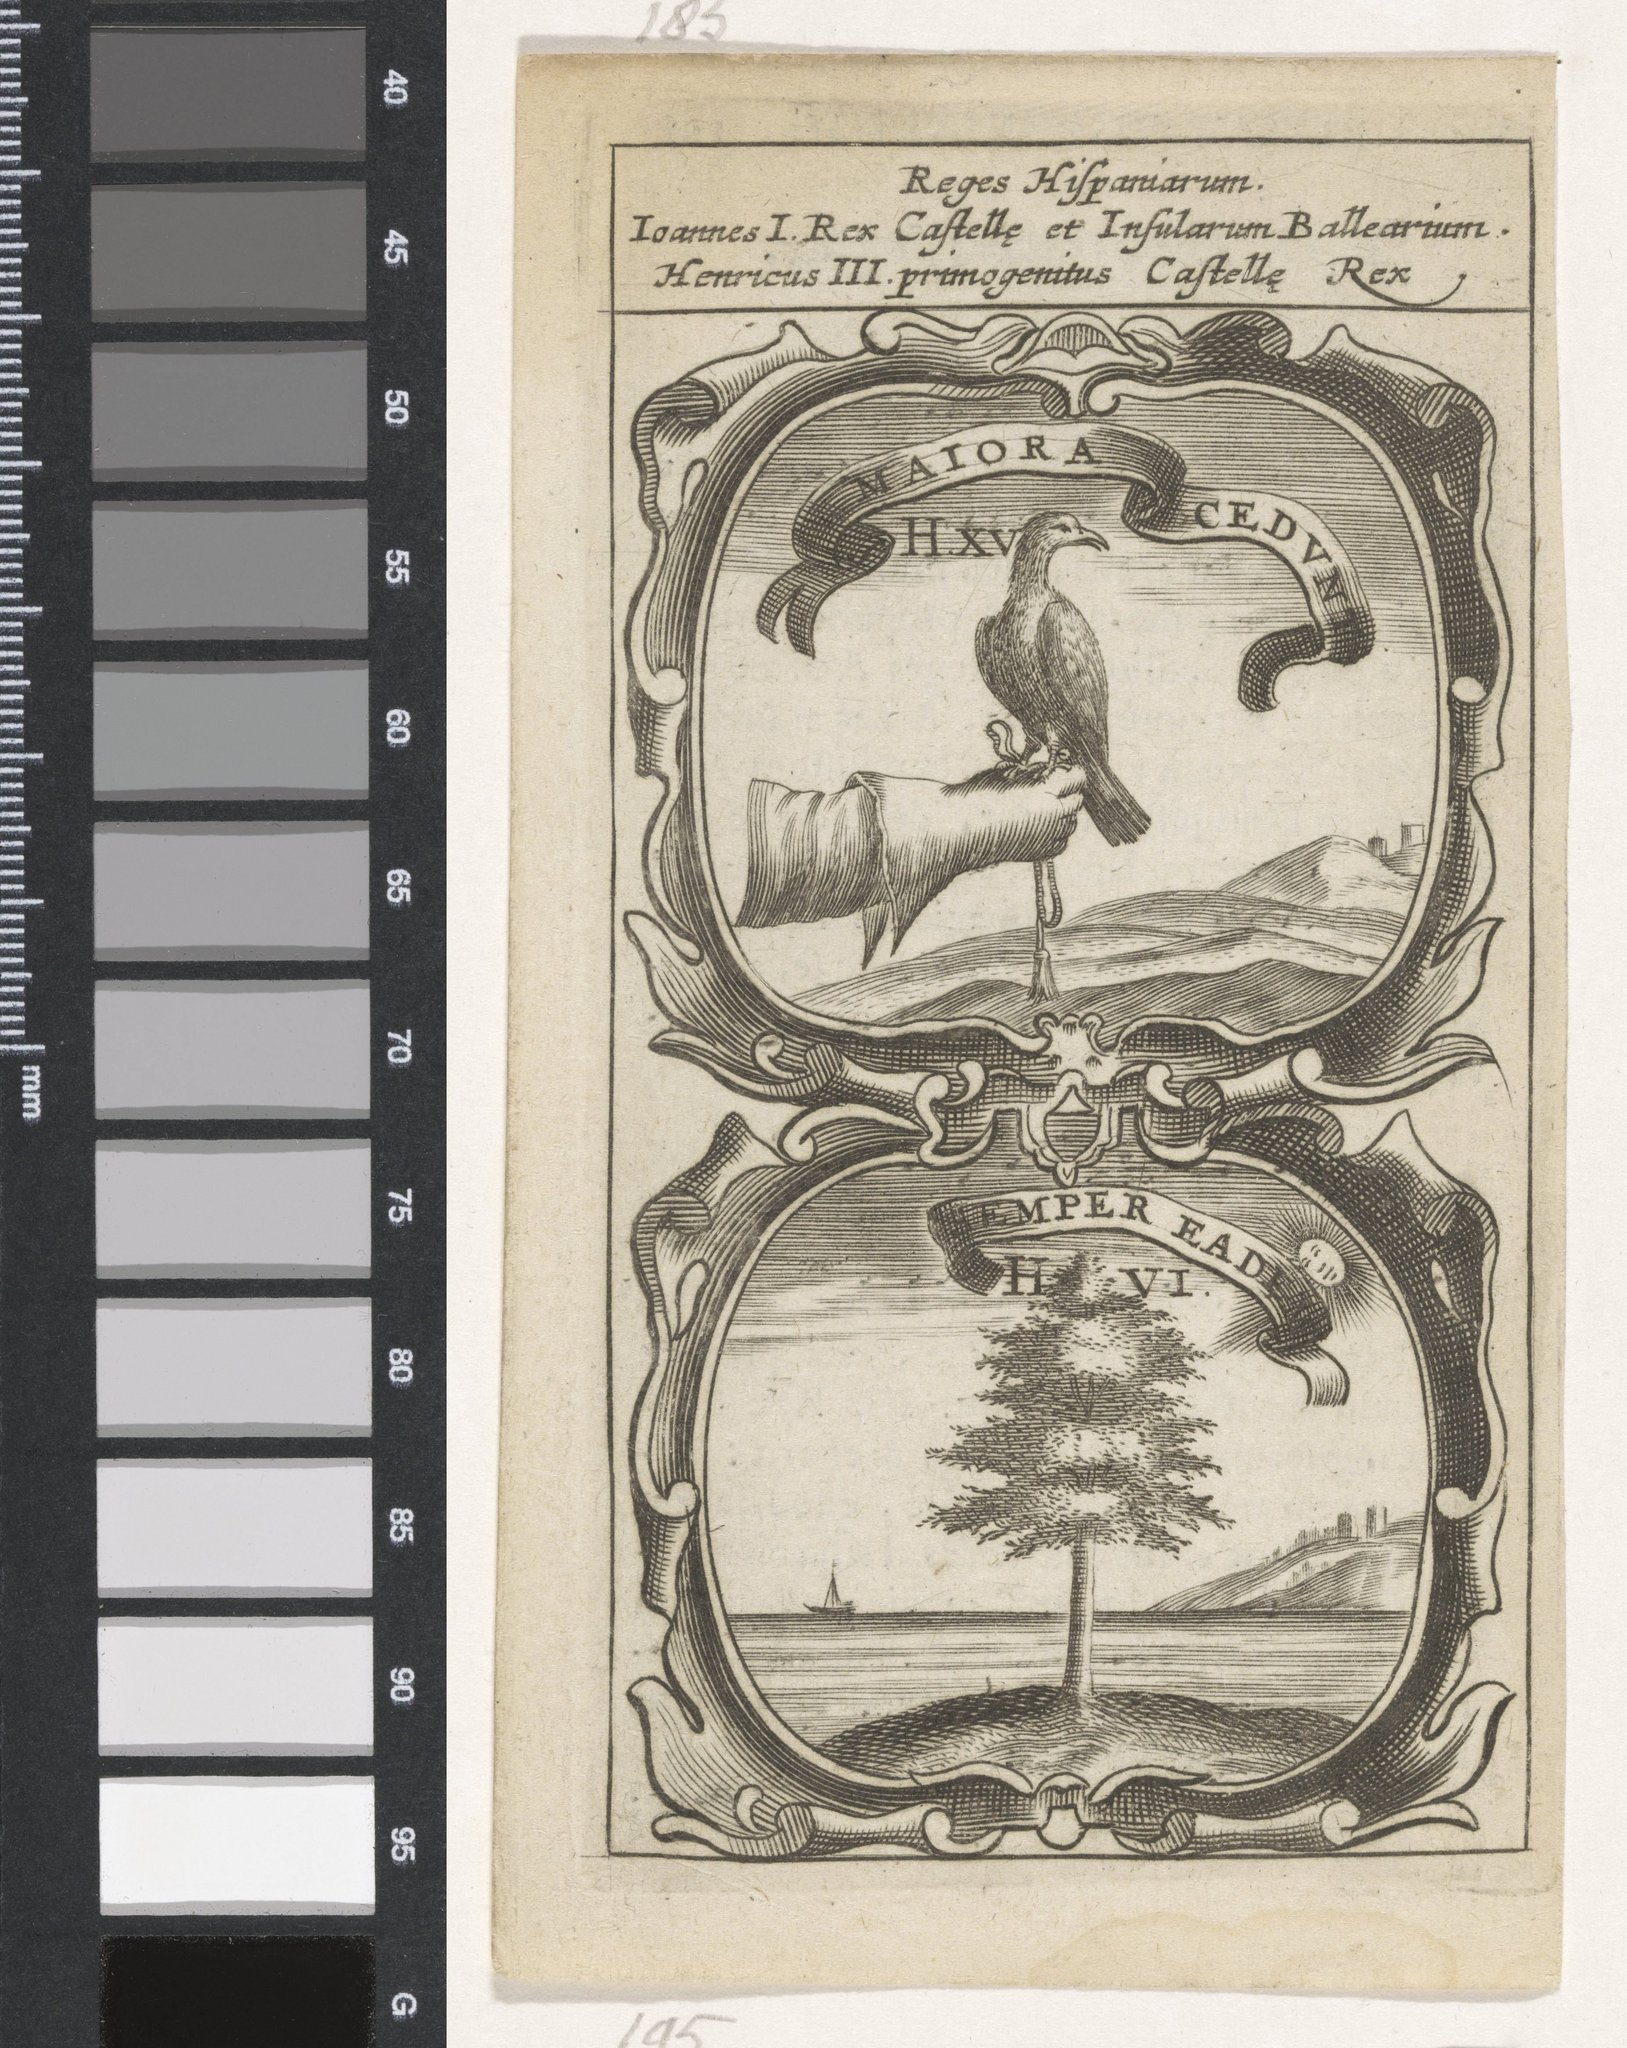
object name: print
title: Symbola Divina et Humana Pontificum Imperatorum Regum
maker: Anonymous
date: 1666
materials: paper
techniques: engraving, letterpress printing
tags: predatory birds: falcon, trees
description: Pagina uit Jacob Typotius, Symbola Divina & Humana Pontificum Imperatorum Regum. Arnhem, J.F. Hagen, 1666 of uit de titeluitgave van 1669 of 1679. Het werk van Typotius werd voor het eerst uitgegeven in 1601 met prenten van Aegidius Sadeler.